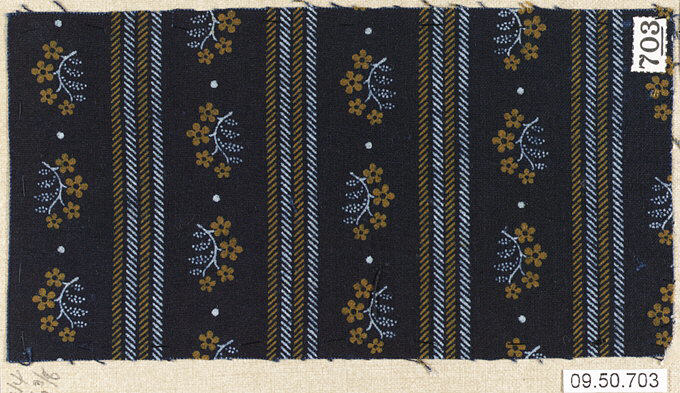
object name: piece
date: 1801-1900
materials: cotton